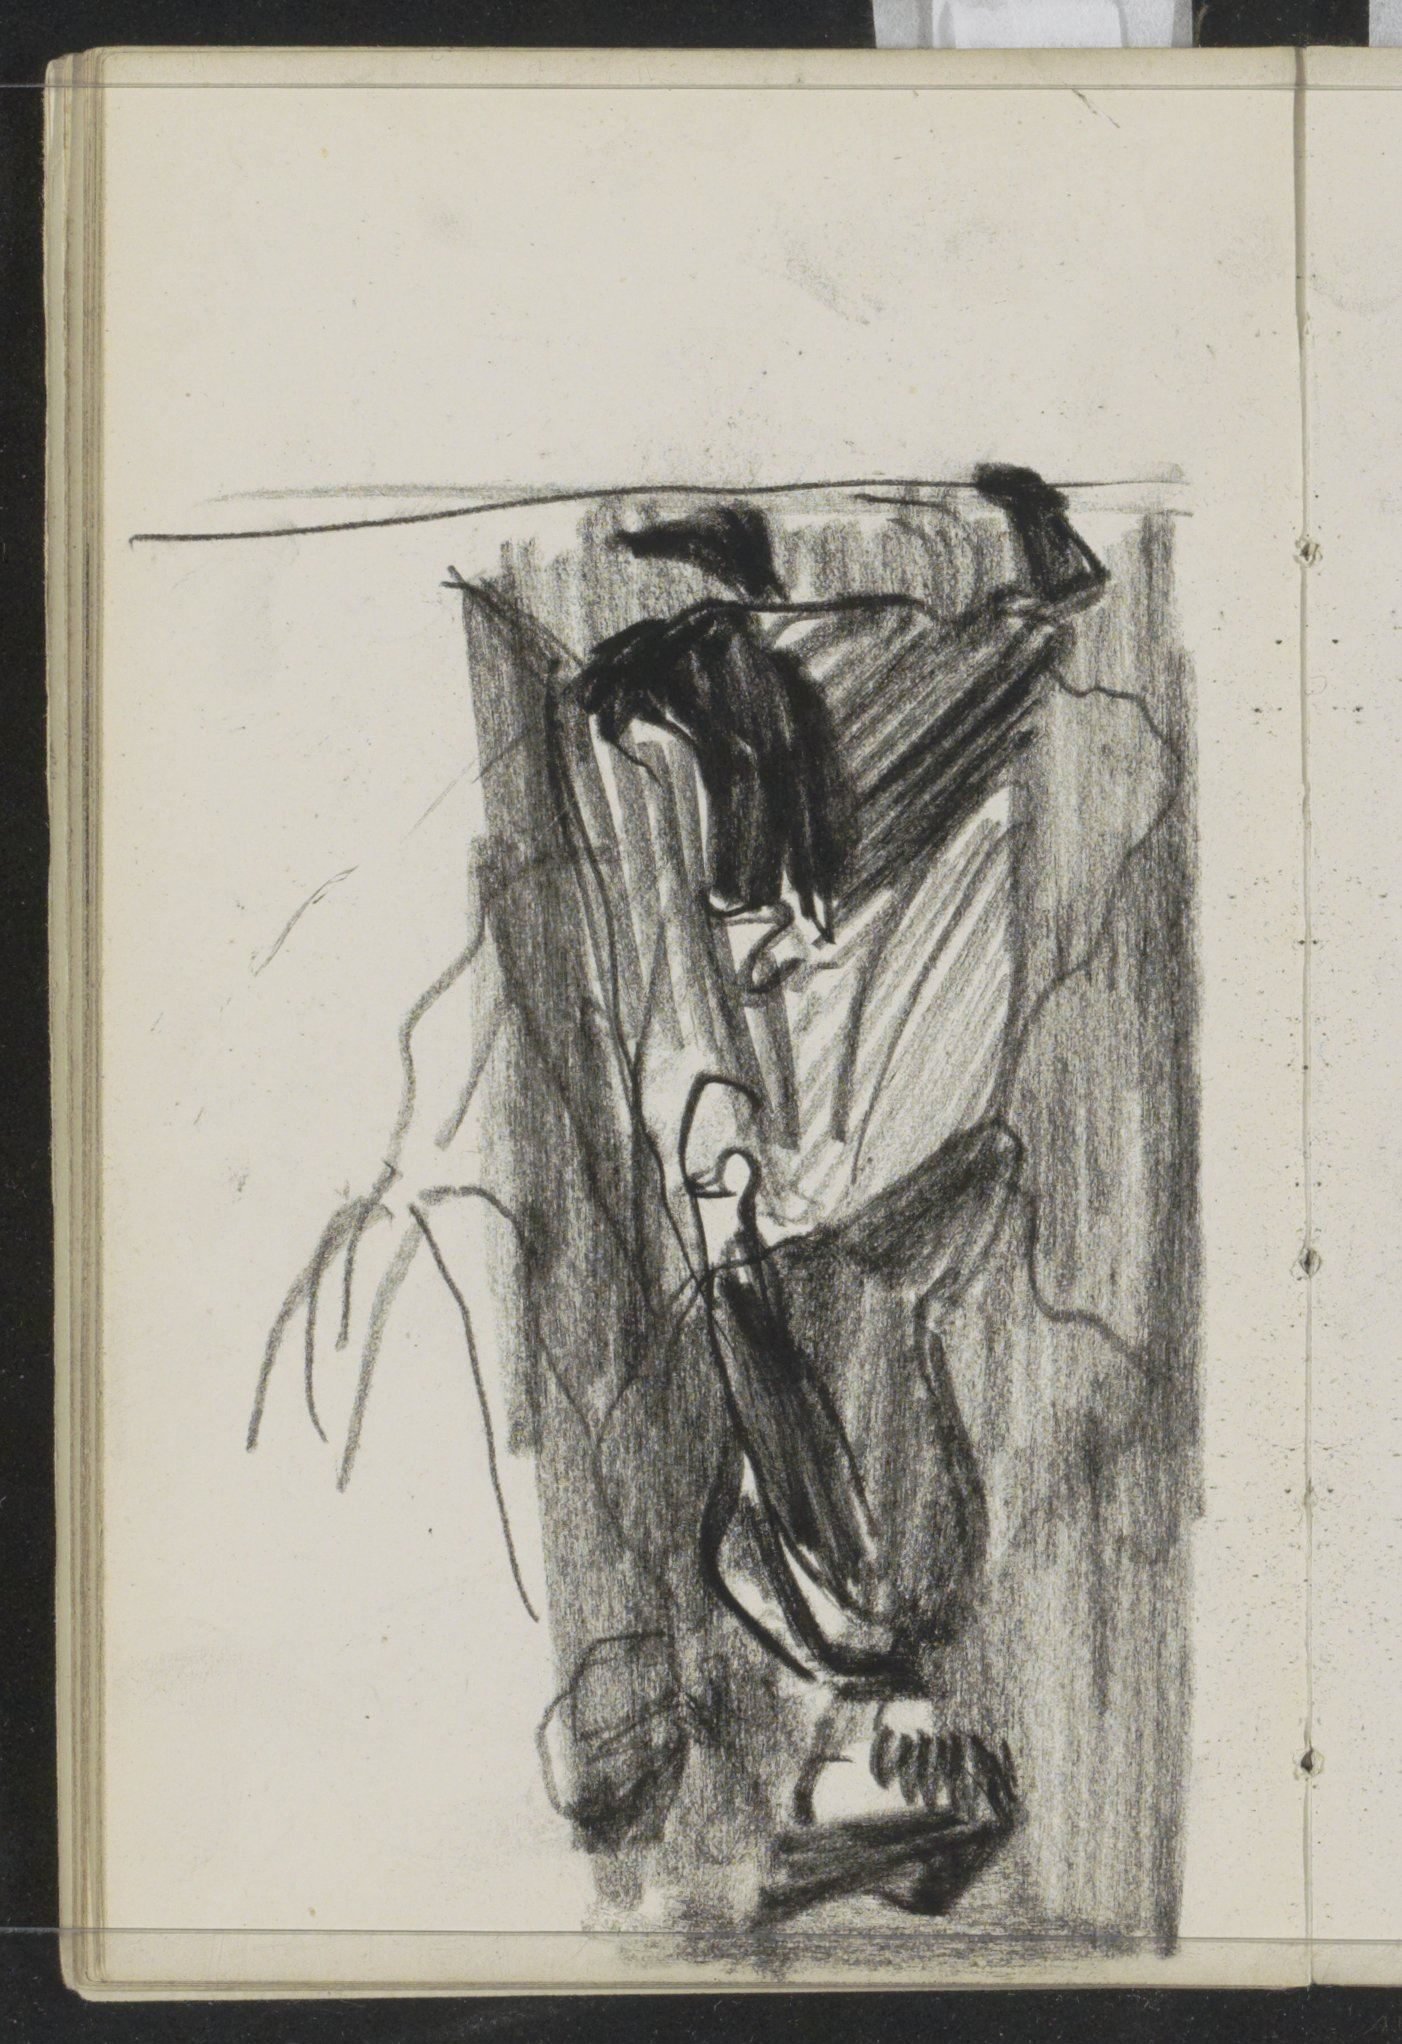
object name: sketchbook leaf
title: Lopende vrouw met een hoed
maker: carel adolph lion cachet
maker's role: draughtsman, print maker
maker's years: 1864-1945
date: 1874-1945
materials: chalk, paper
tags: walking (+ female (human being) (not to be used where -aa- is prescribed)), head-gear: hat (+ women's clothes)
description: Blad 31 verso uit een schetsboek met 41 bladen.